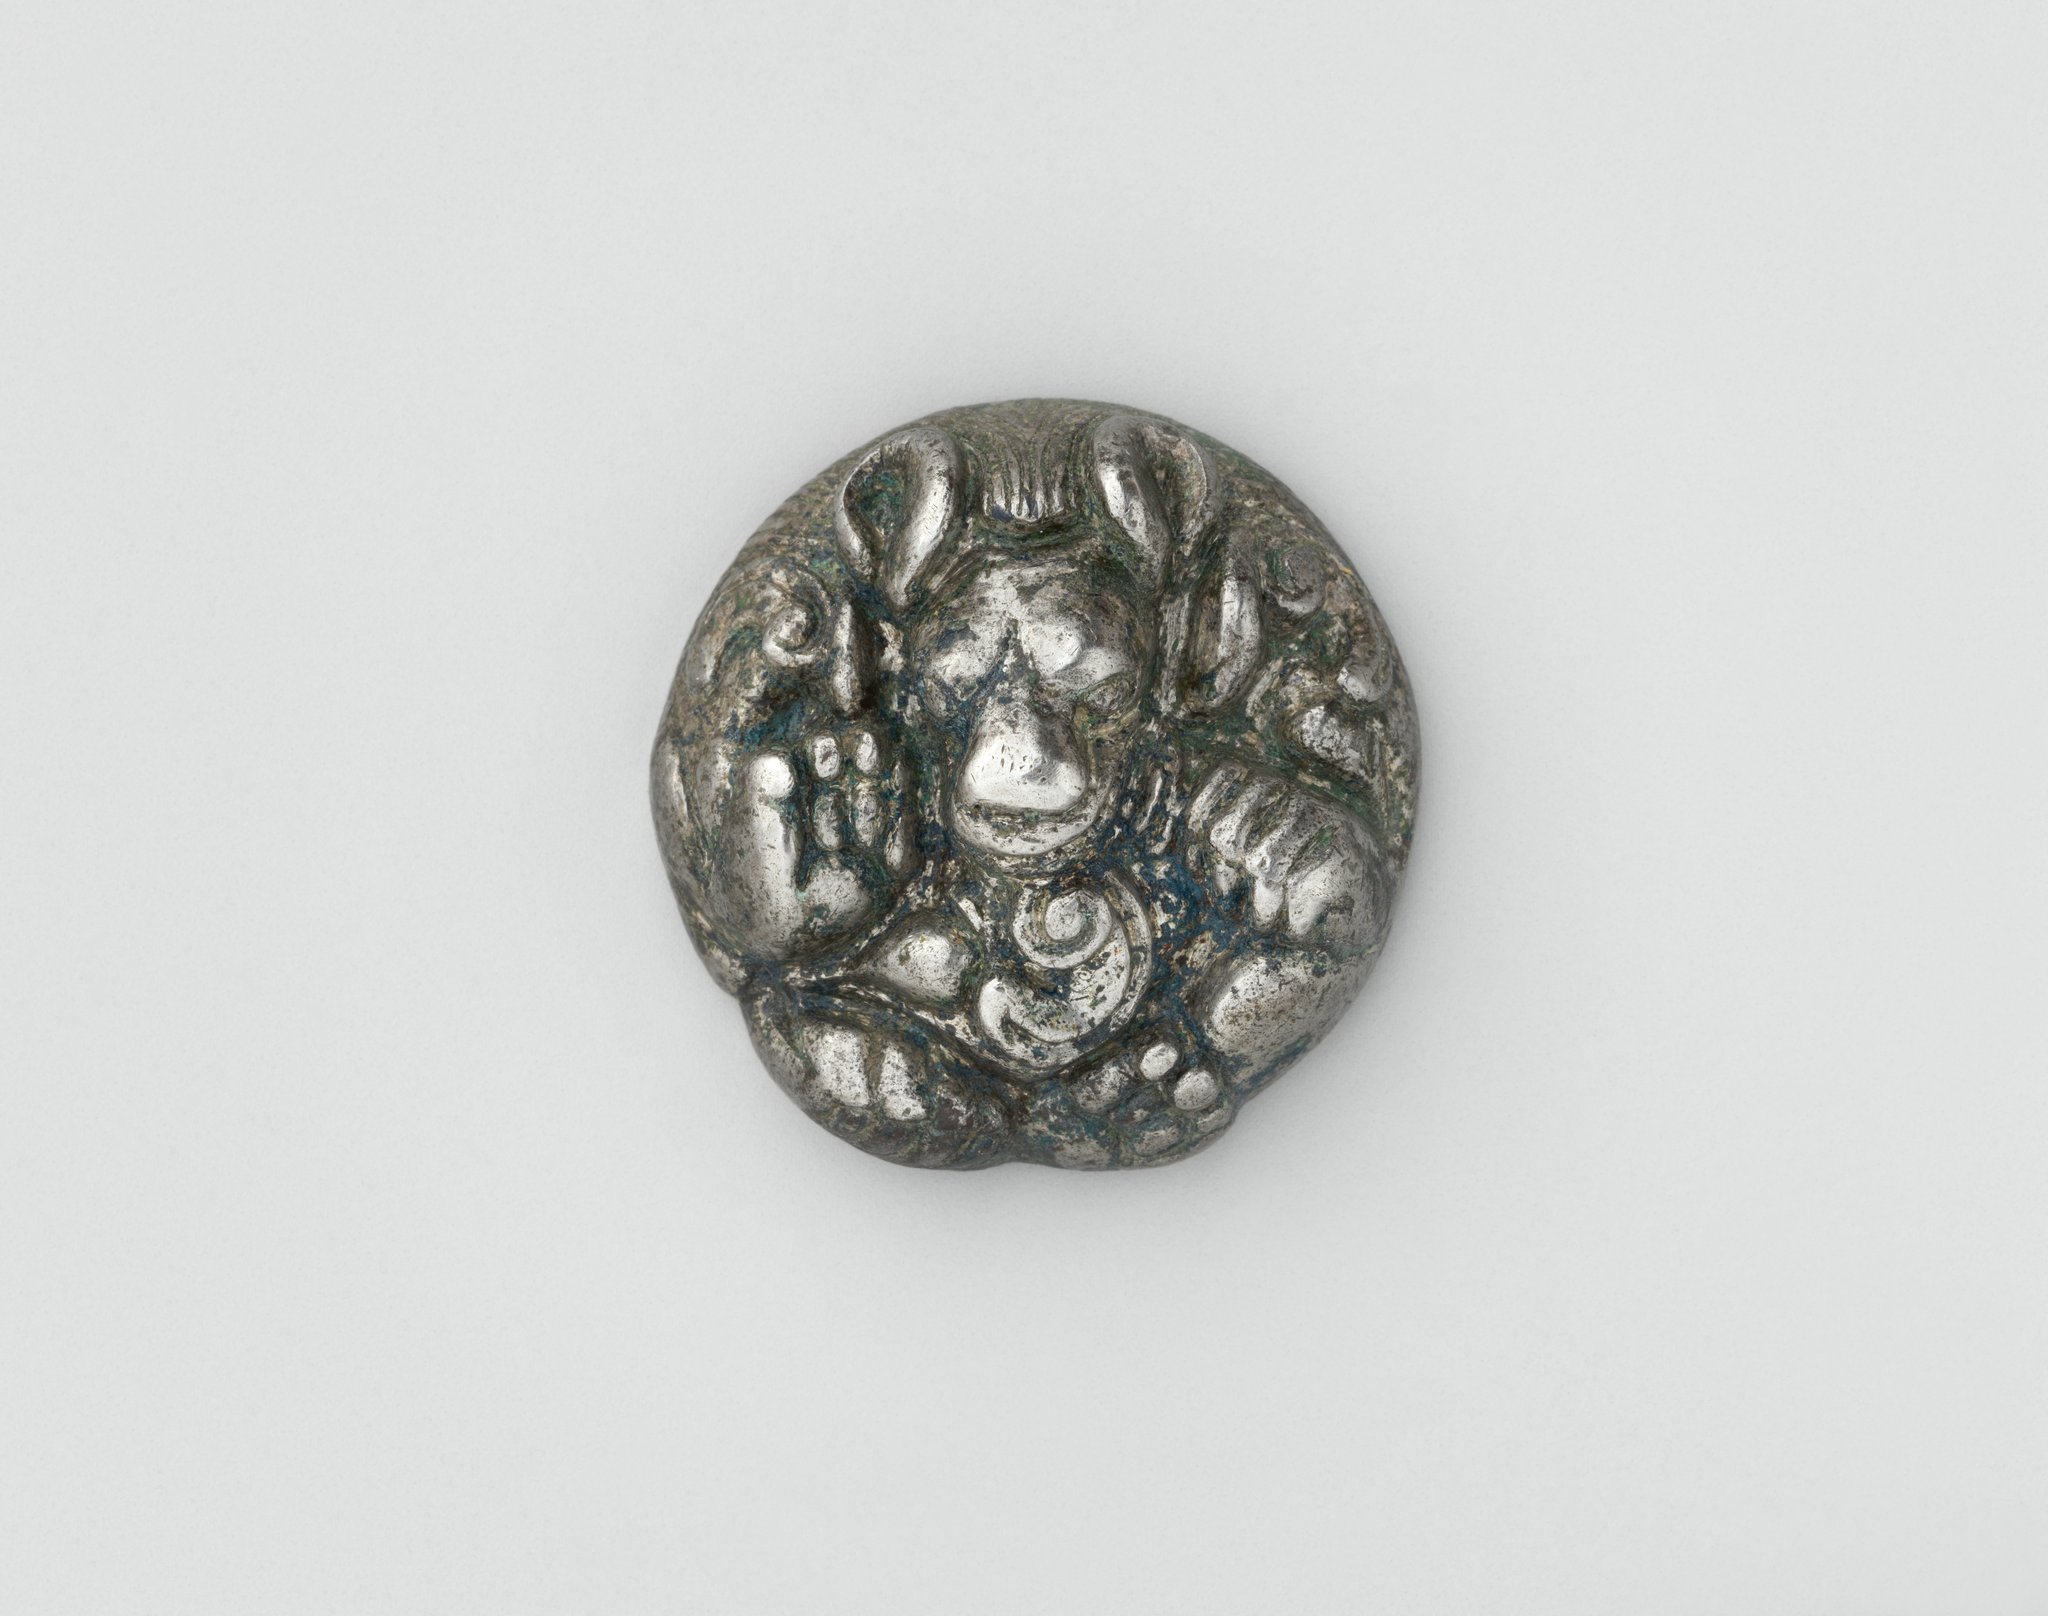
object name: strap crossing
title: Strap Crossing with Crouching Bear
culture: north chinese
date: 300-101 BCE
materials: silver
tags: bears